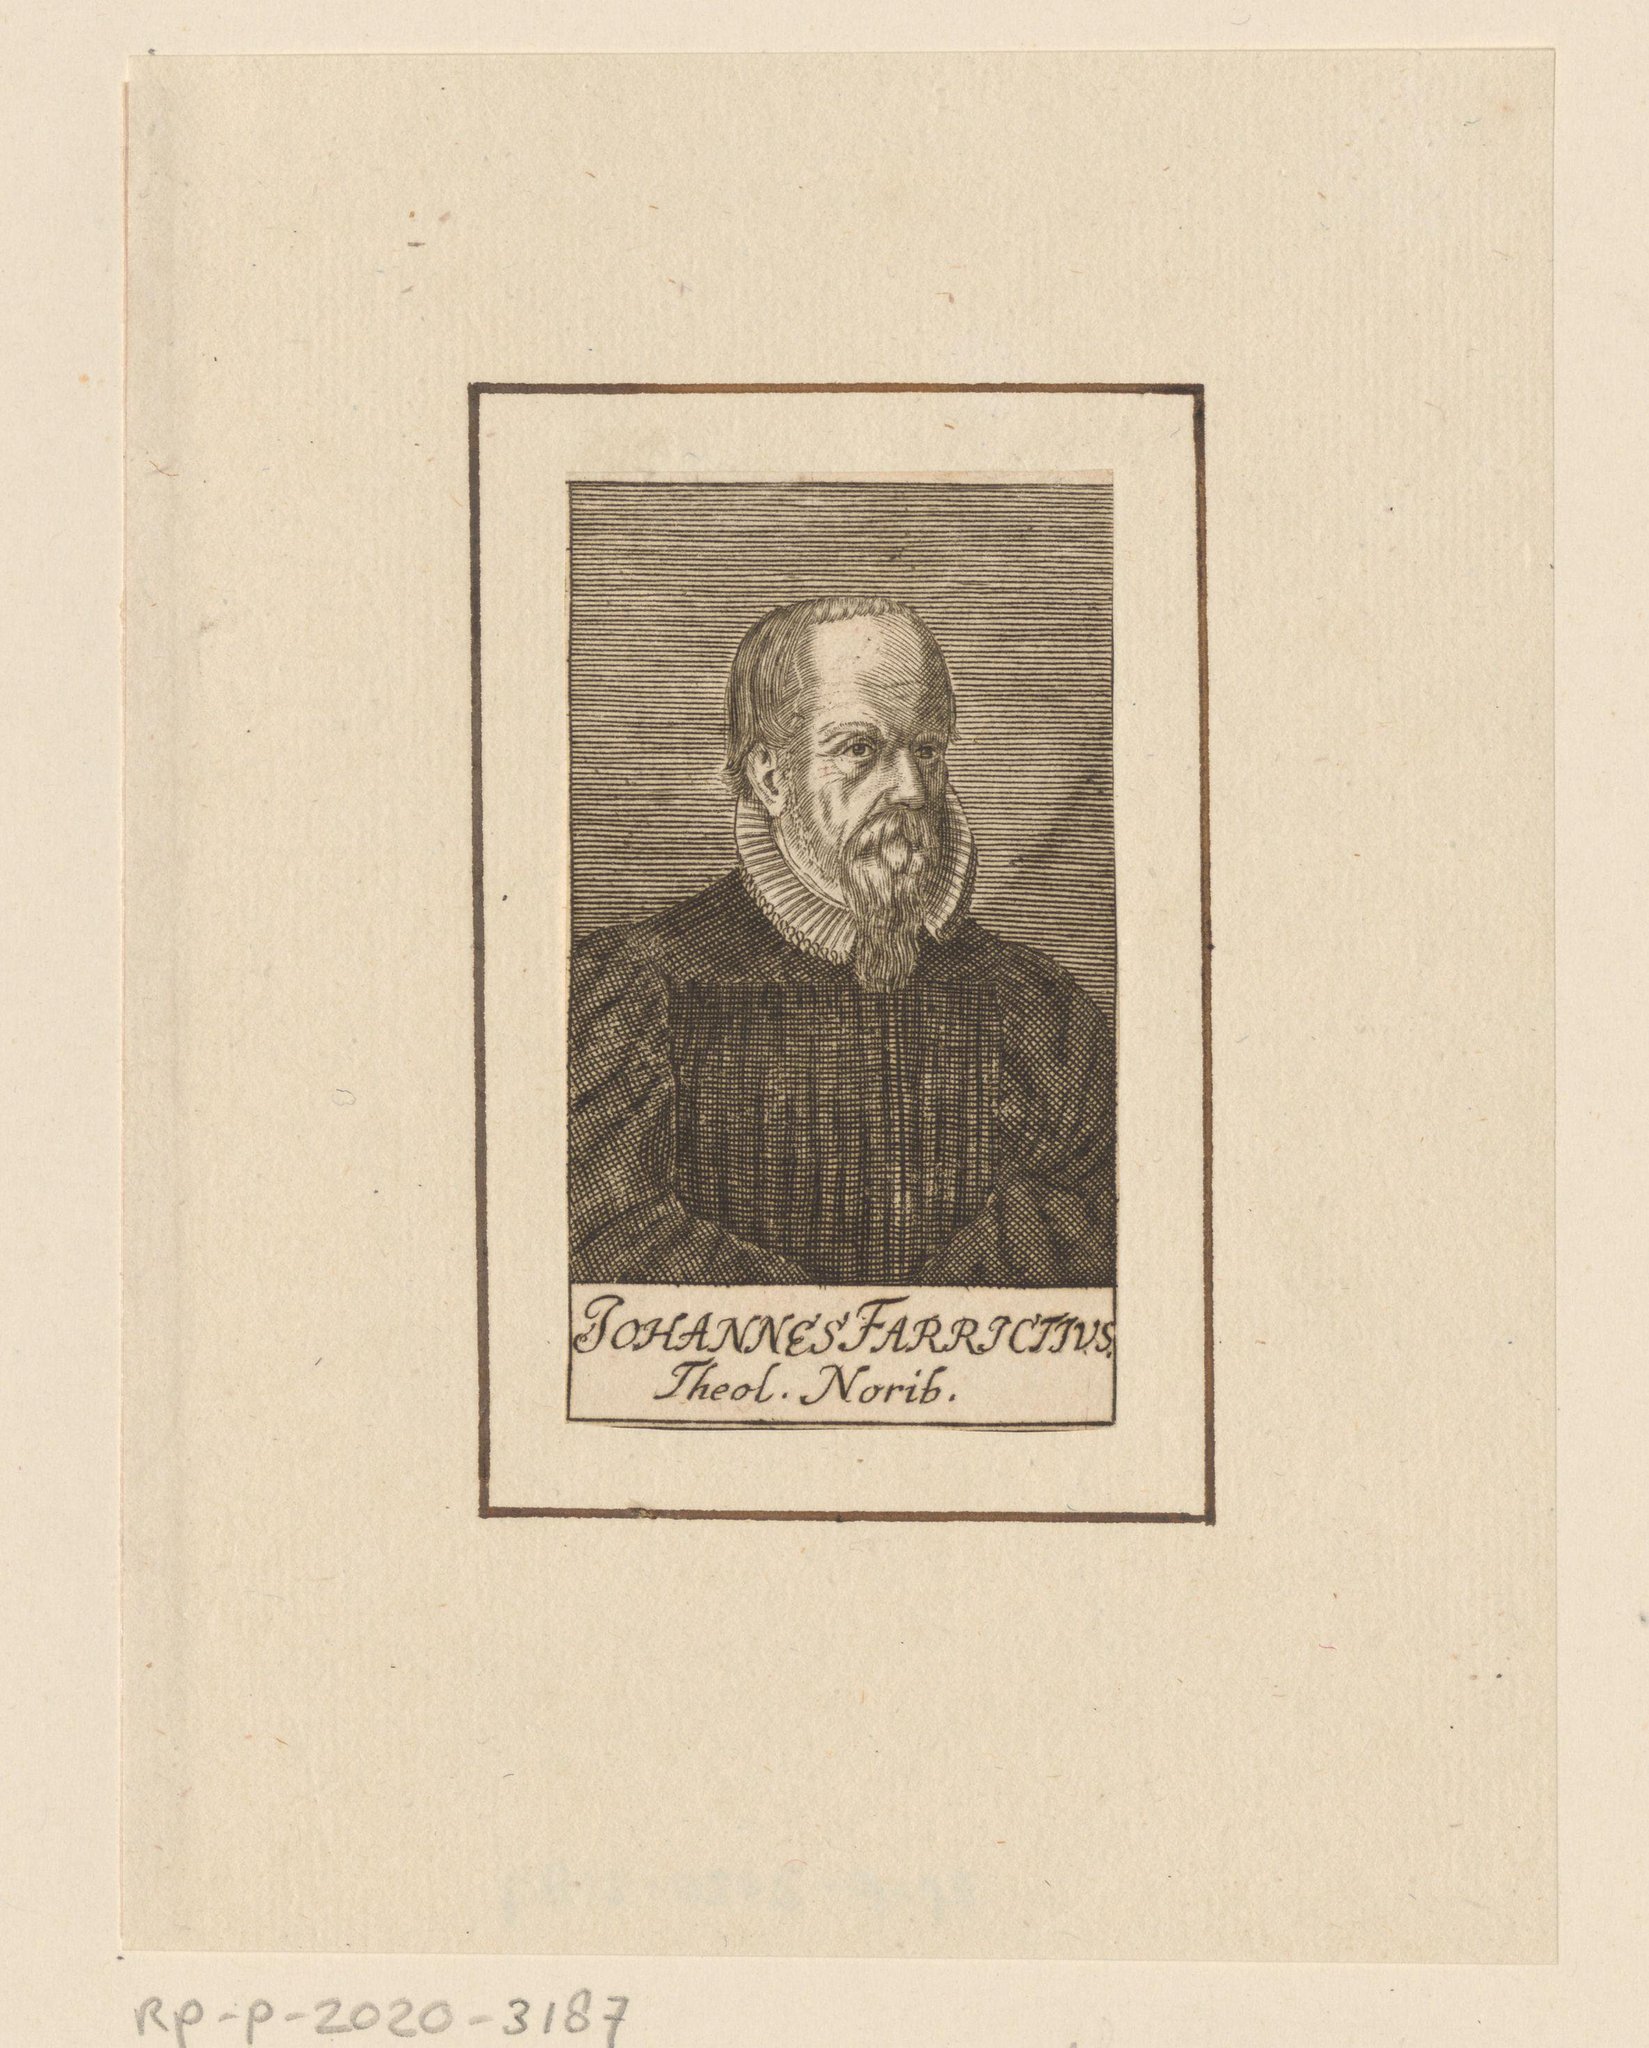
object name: book illustration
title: Portret van Johann Fabricius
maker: Anonymous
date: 1688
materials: paper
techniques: engraving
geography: germany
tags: theologian, historical persons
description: Prent waarschijnlijk uit: Freher, Paul. Theatrum virorum eruditione clarorum. Neurenberg: Johann Hoffmann, 1688.